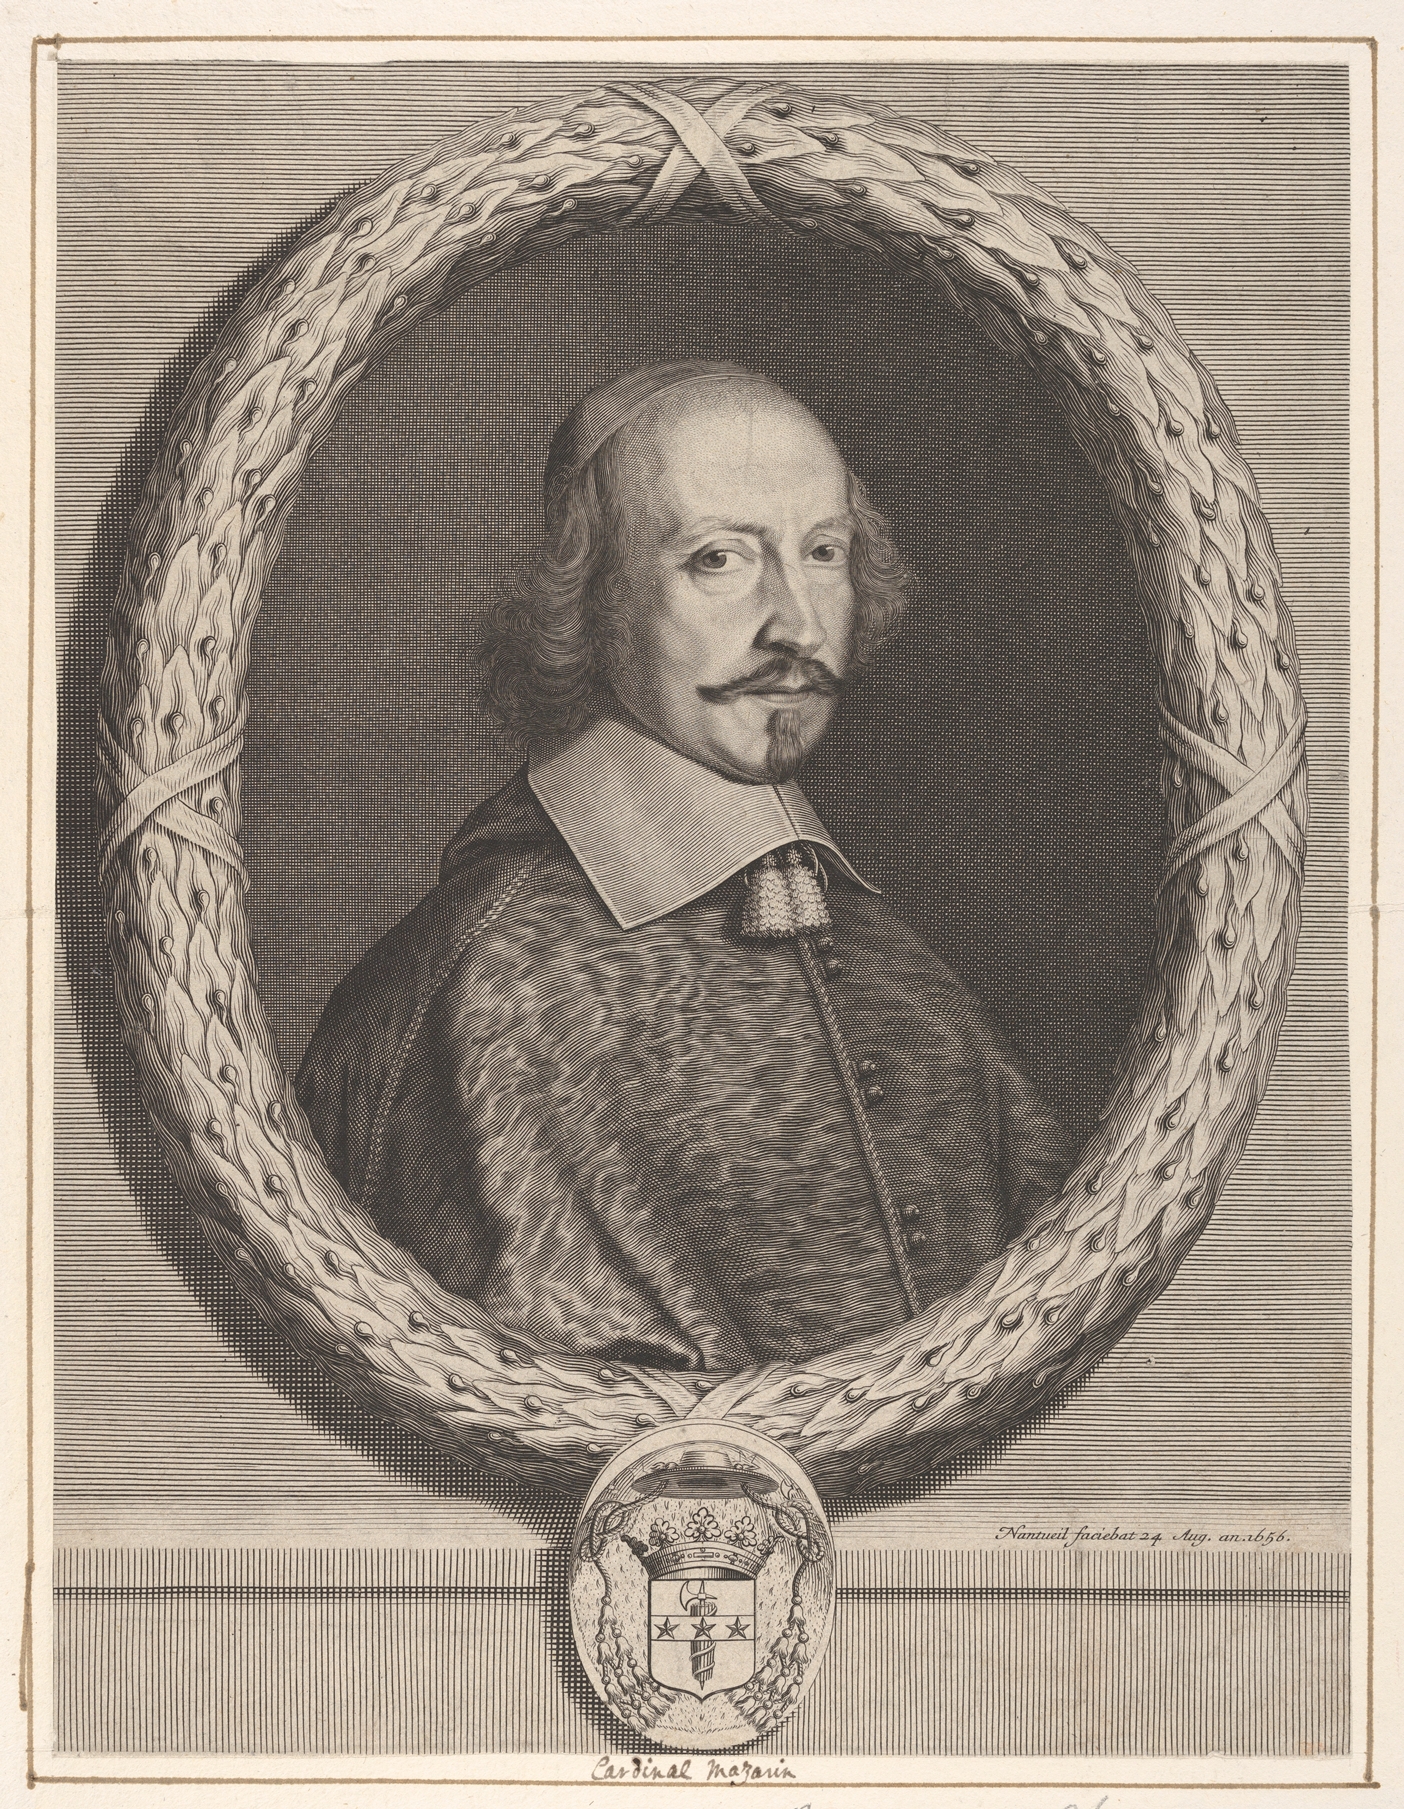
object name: print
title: Cardinal Jules Mazarin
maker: robert nanteuil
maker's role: artist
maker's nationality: french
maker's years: 1623-1678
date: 1656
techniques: engraving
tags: men,portraits,coat of arms